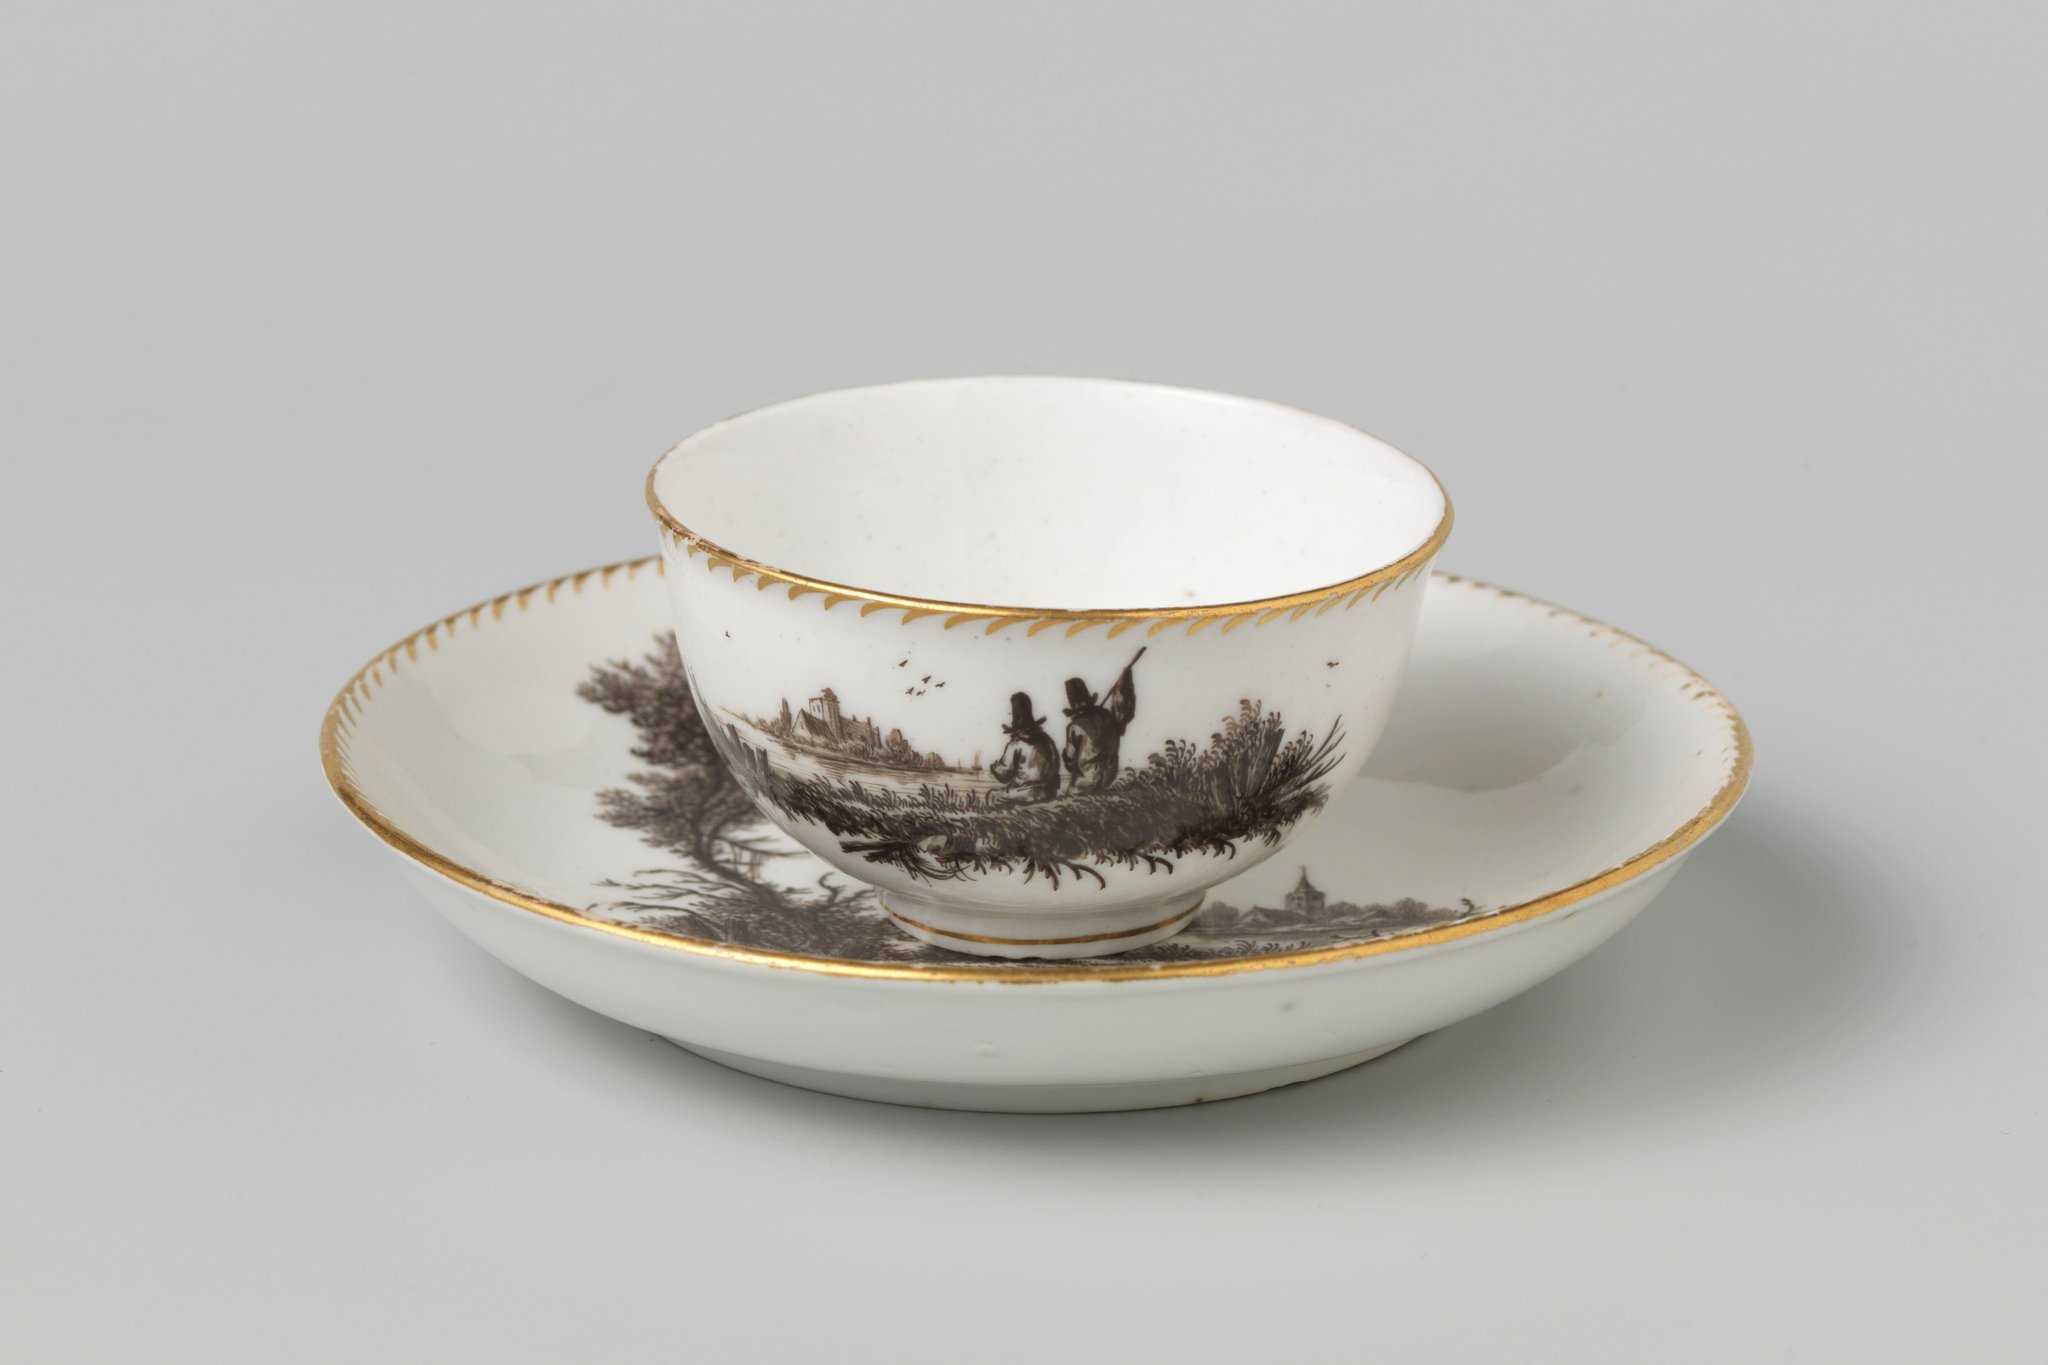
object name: cup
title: Kop met riviergezicht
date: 1774-1784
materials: porcelain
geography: loosdrecht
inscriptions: collector's mark: ‘19. (geschreven in bruine inkt)’, mark: ‘M:OL’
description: Kop en schotel van porselein. Beschilderd met een riviergezicht met op de voorgrond twee mansfiguren en een grote boom. Alle randen in goud.